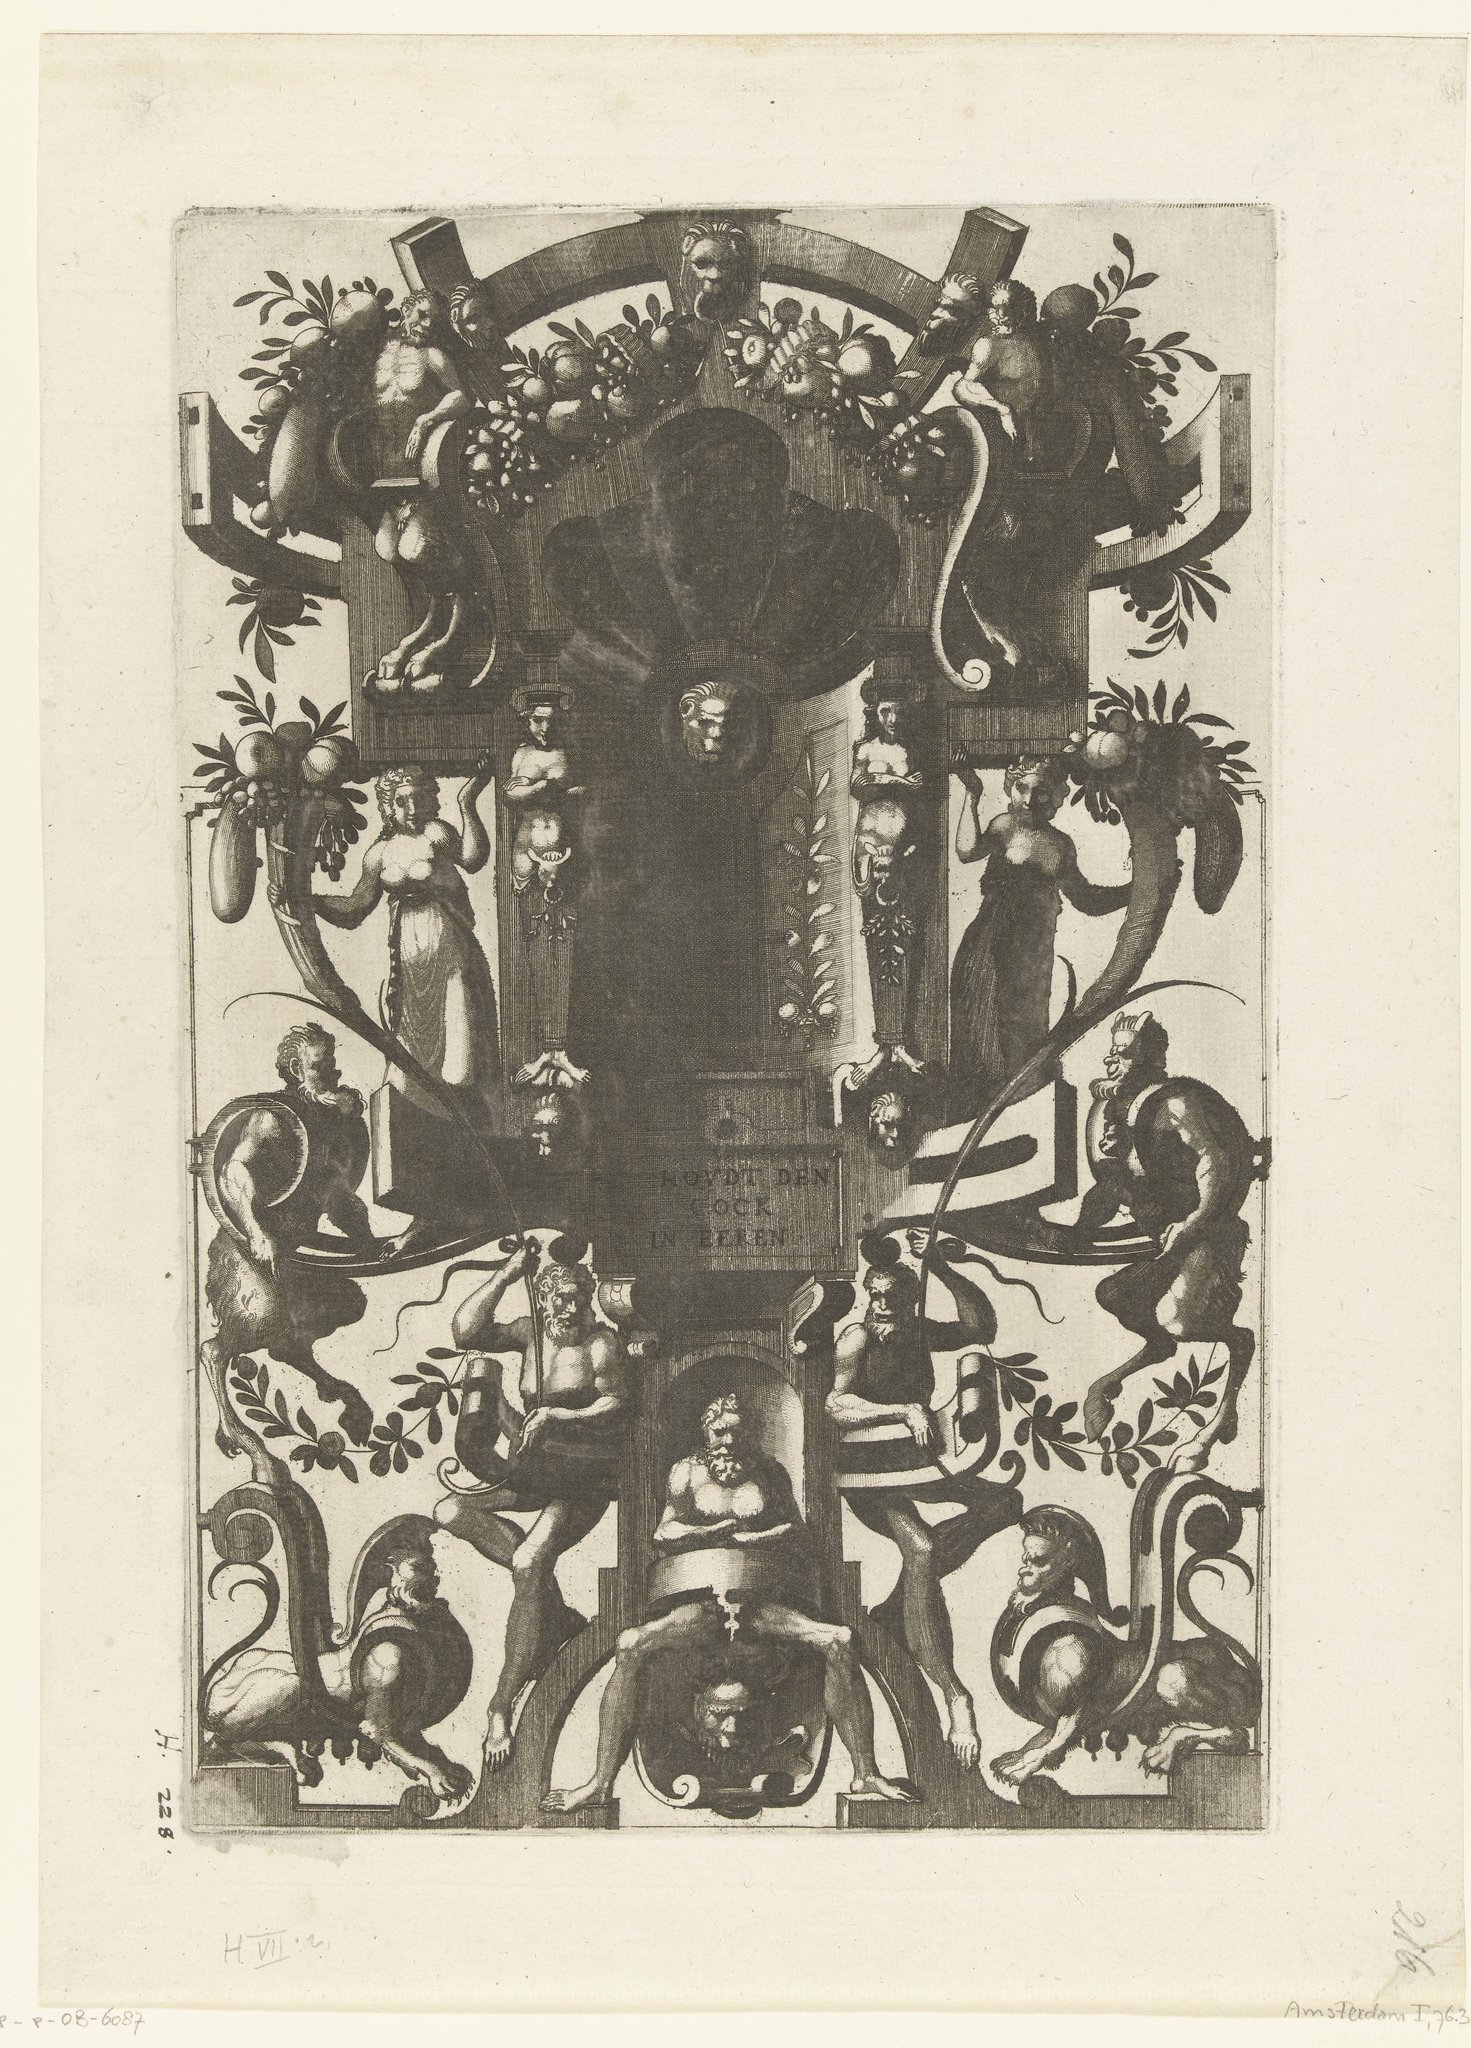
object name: ornament print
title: Vlakdecoraties en grafmonumenten / Veelderleij niewe inventien (...)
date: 1557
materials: paper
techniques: etching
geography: netherlands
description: Nis, geflankeerd door vrouwelijke hermen, waarboven guirlandes van vruchten. Onder de nis hangt een cartouche met de tekst HOUDT DEN COCK IN EEREN. Daaronder zitten drie mannen gevangen in het rolwerk. De man aan de buitenzijden houden een hoorn des overvloeds omhoog. De middelste man zit wijdbeens: onder zijn benen een masker. Hoort bij serie bestaande uit een titelblad, een tekstblad en 14 bladen met grotesken met rolwerk, saters, guirlandes, trofeeën, dieren en fantasiewezens.